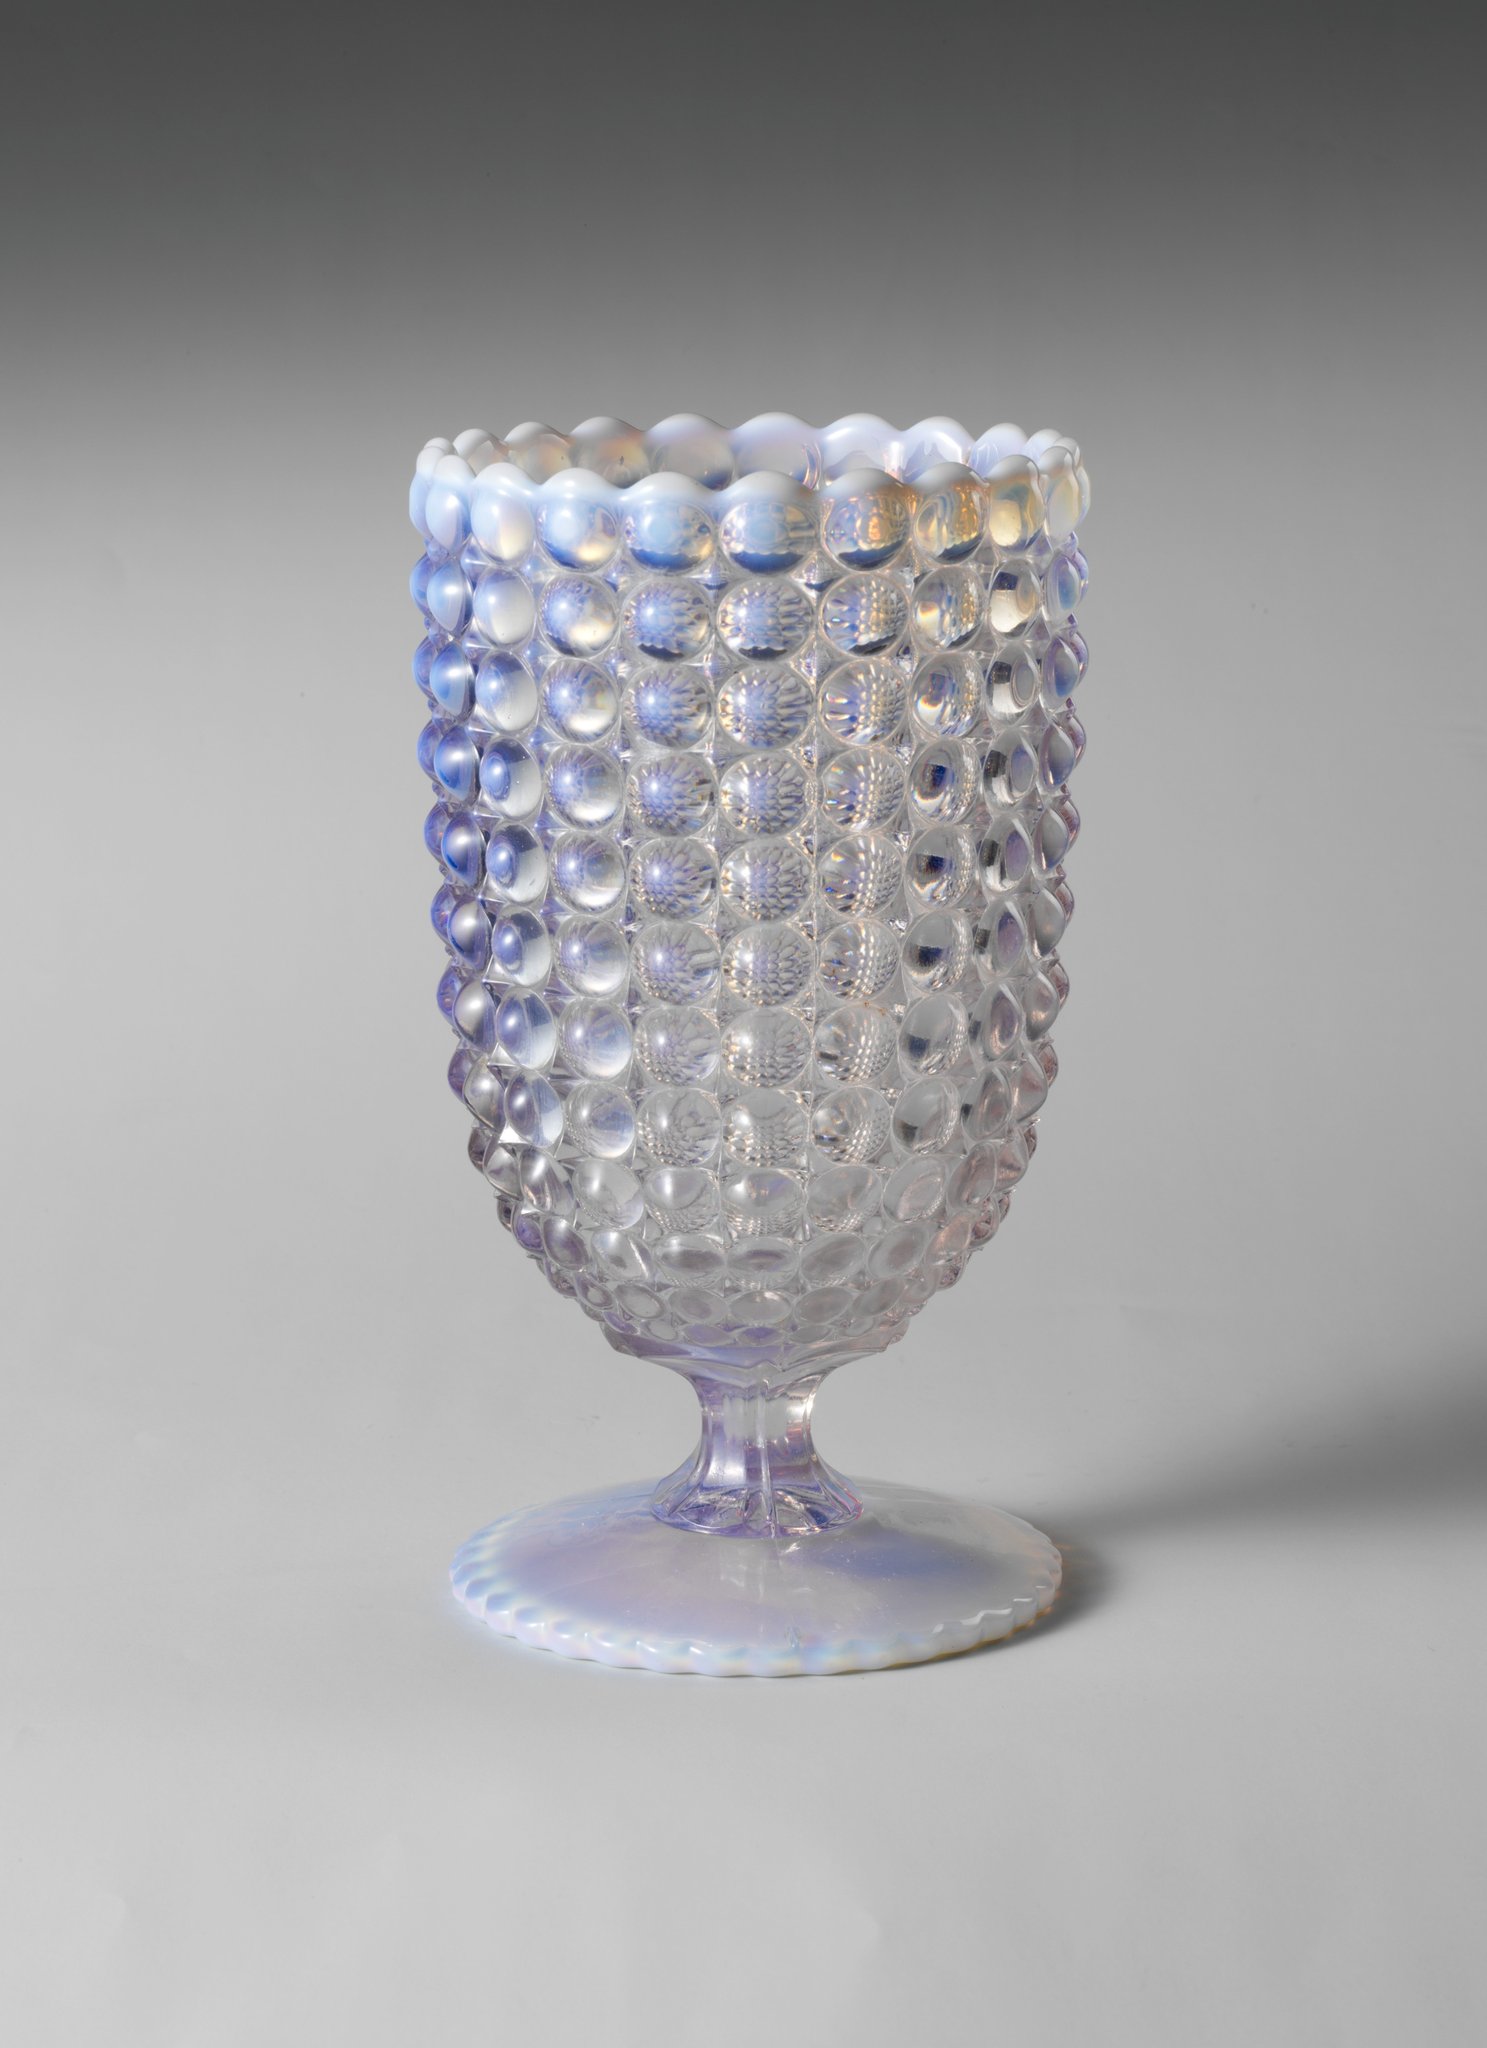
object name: celery vase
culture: american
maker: richards and hartley flint glass co.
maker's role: maker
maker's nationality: american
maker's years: 1867-1890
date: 1888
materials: glass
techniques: pressed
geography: united states